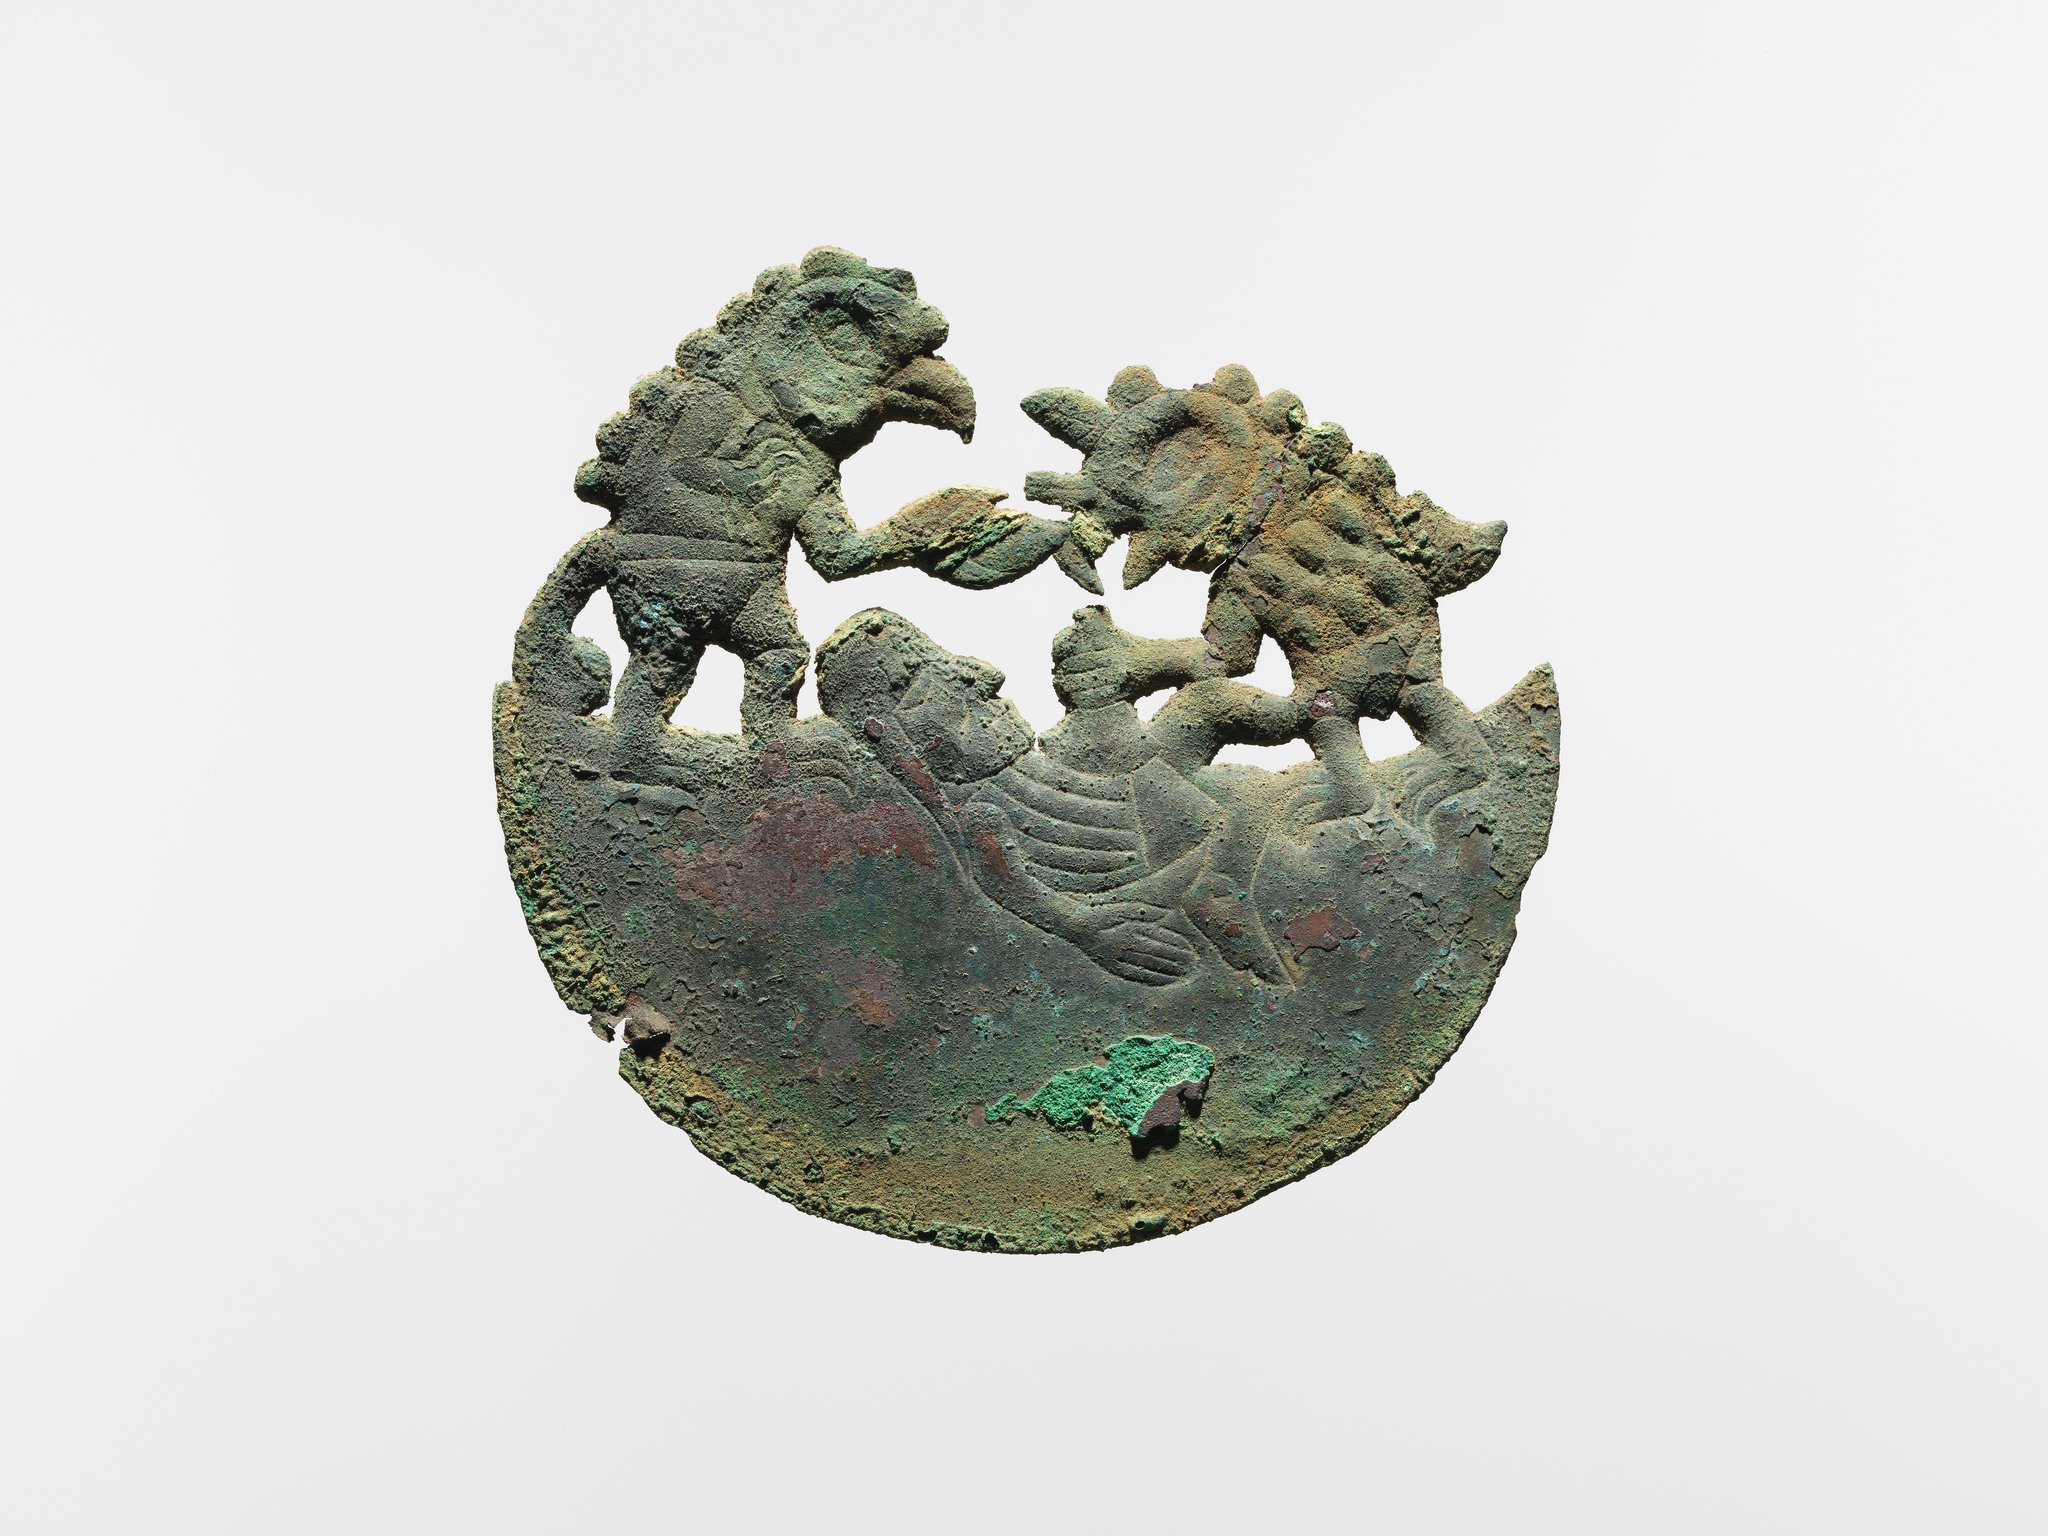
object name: ornament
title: Animal Ornament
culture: moche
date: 501-700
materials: copper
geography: peru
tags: animals